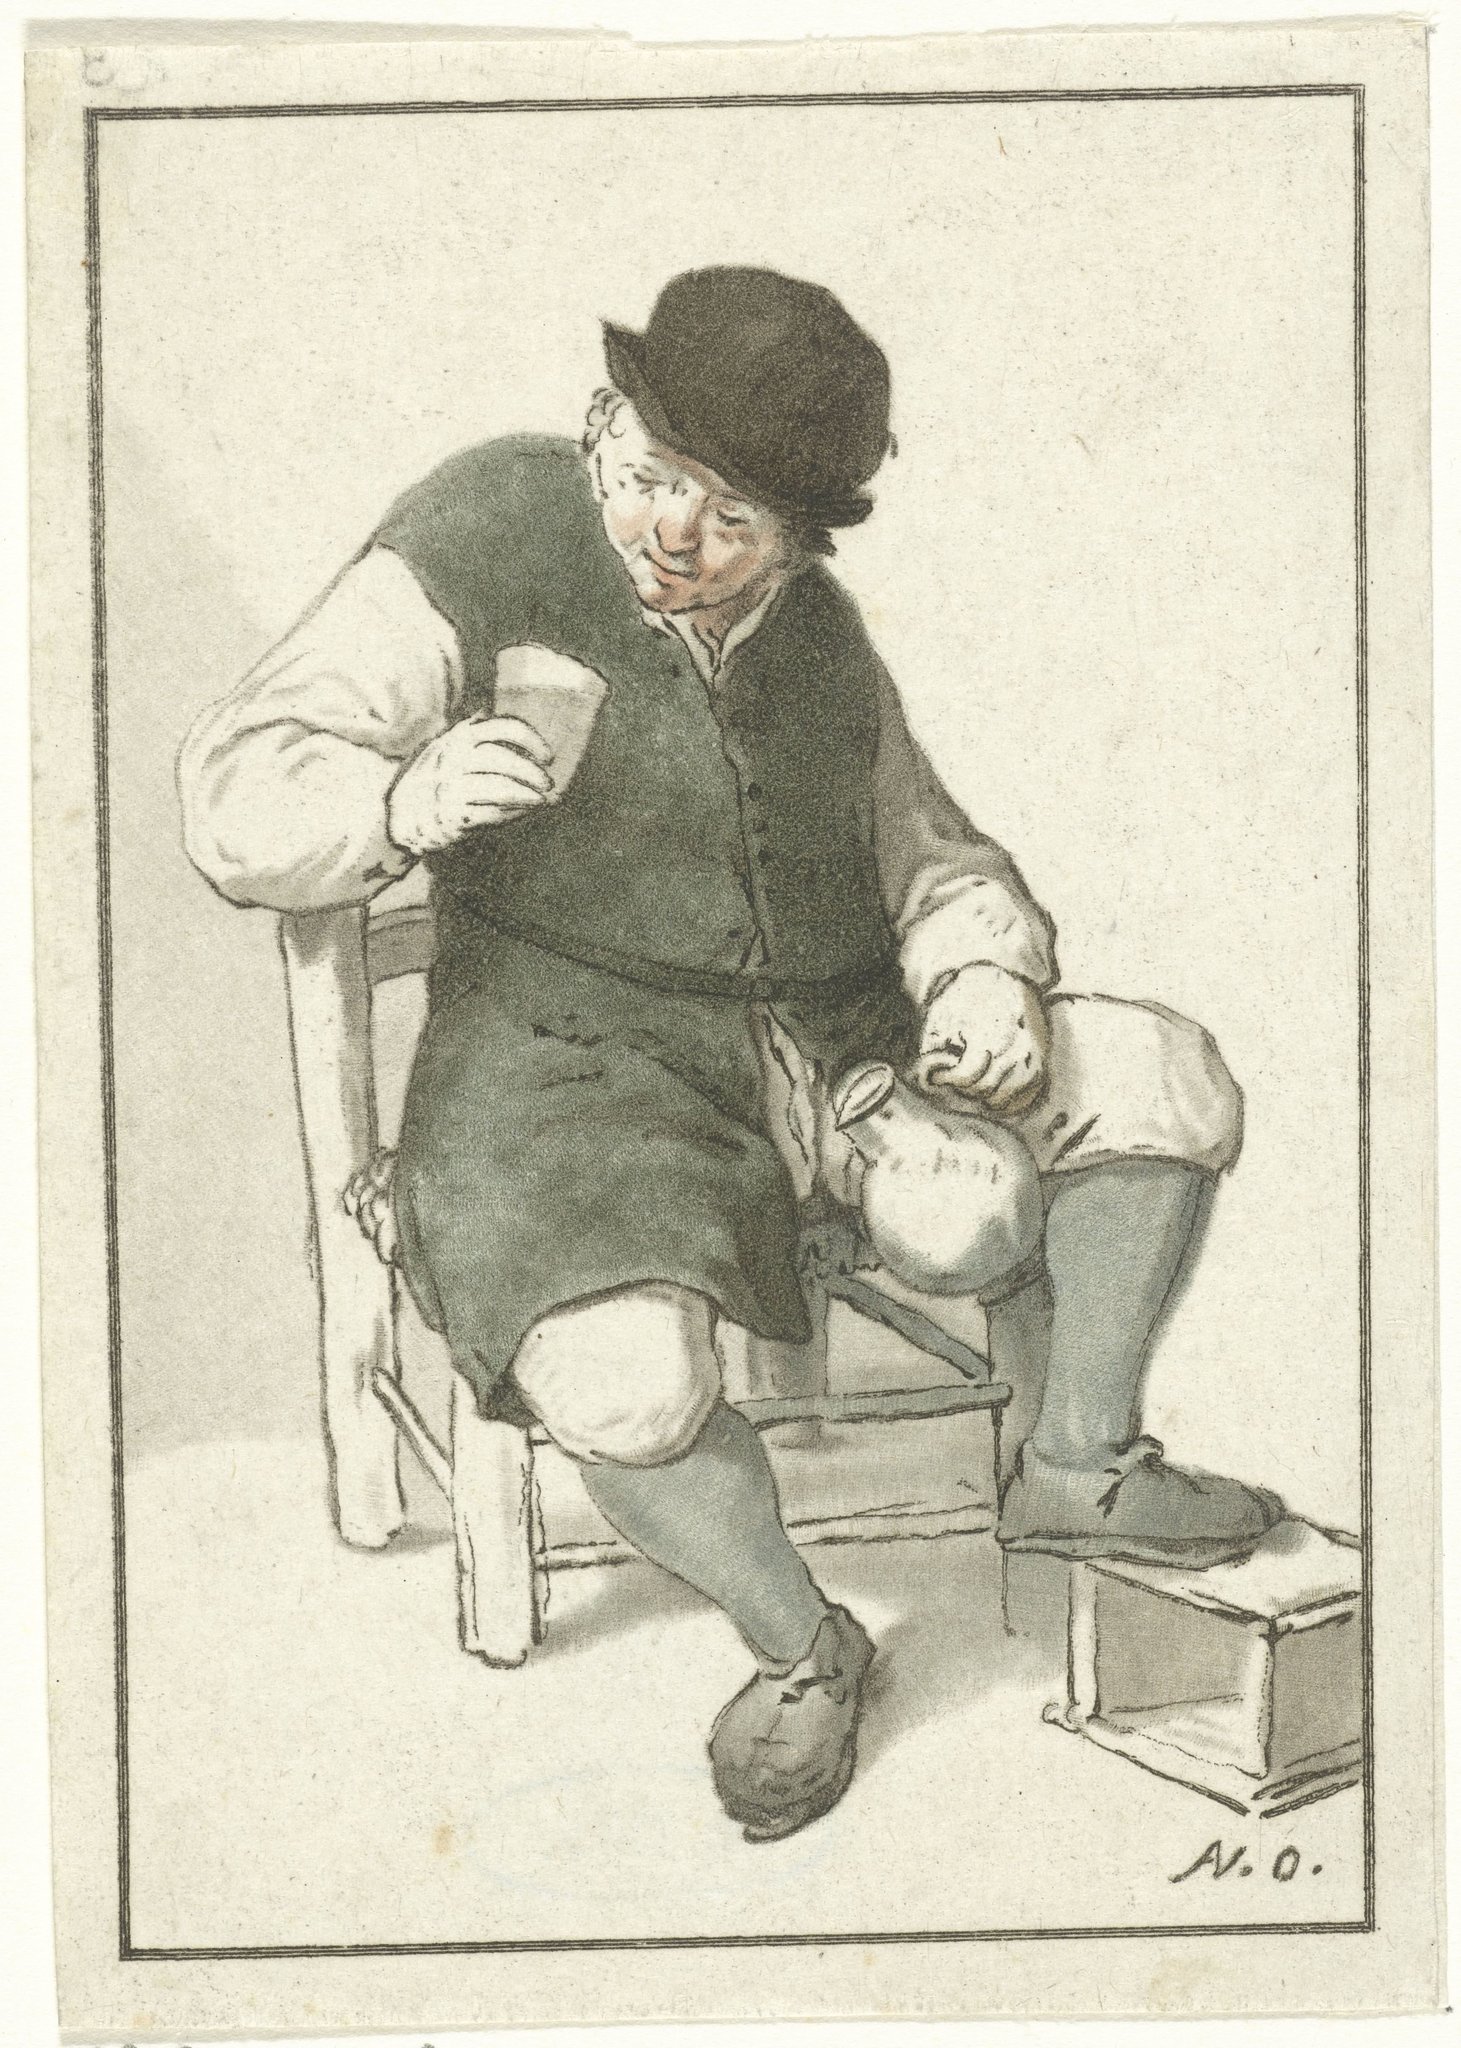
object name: print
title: Zittende boer met kruik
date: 1763-1768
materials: paper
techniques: etching, roulette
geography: amsterdam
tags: sitting figure, jar, jug (used as drinking-vessel)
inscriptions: collector's mark: Lugt 2228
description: Voor deze prenttekening, 'Zittende boer met kruik', maakte Ploos van Amstel vier verschillende platen (A, B, C, en D). Er bestaan afdrukken van één, twee, drie of alle vier de platen in alle mogelijke combinaties. Zie gerelateerde objecten voor de hier gebruikte platen.